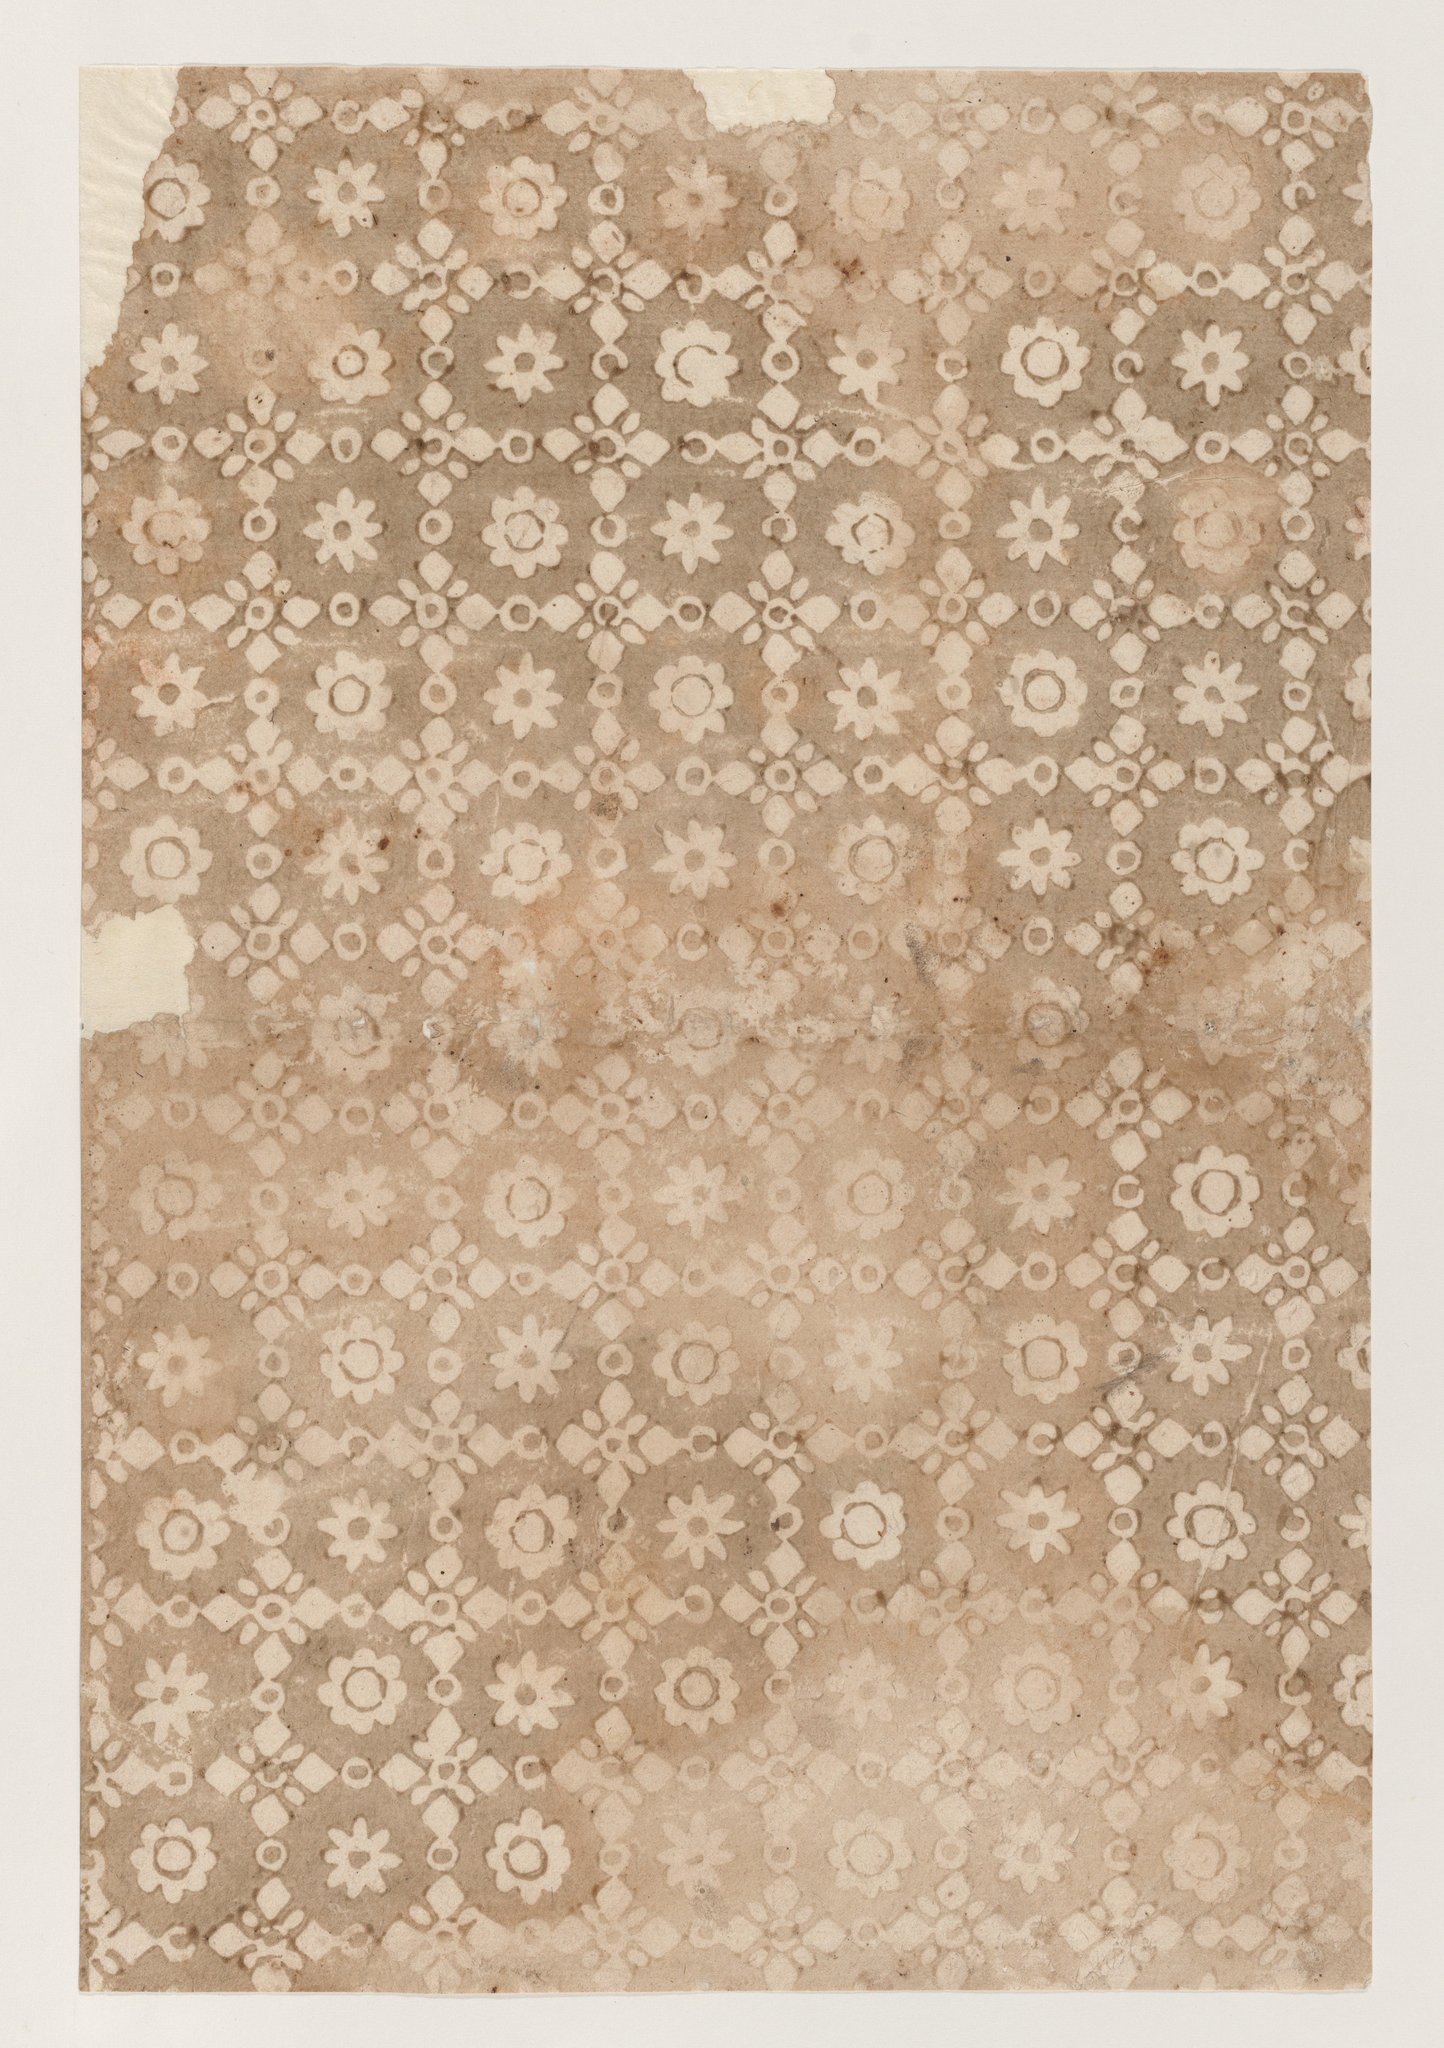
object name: print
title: Sheet with overall floral and geometric pattern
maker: Anonymous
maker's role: artist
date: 1801-1900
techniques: relief print